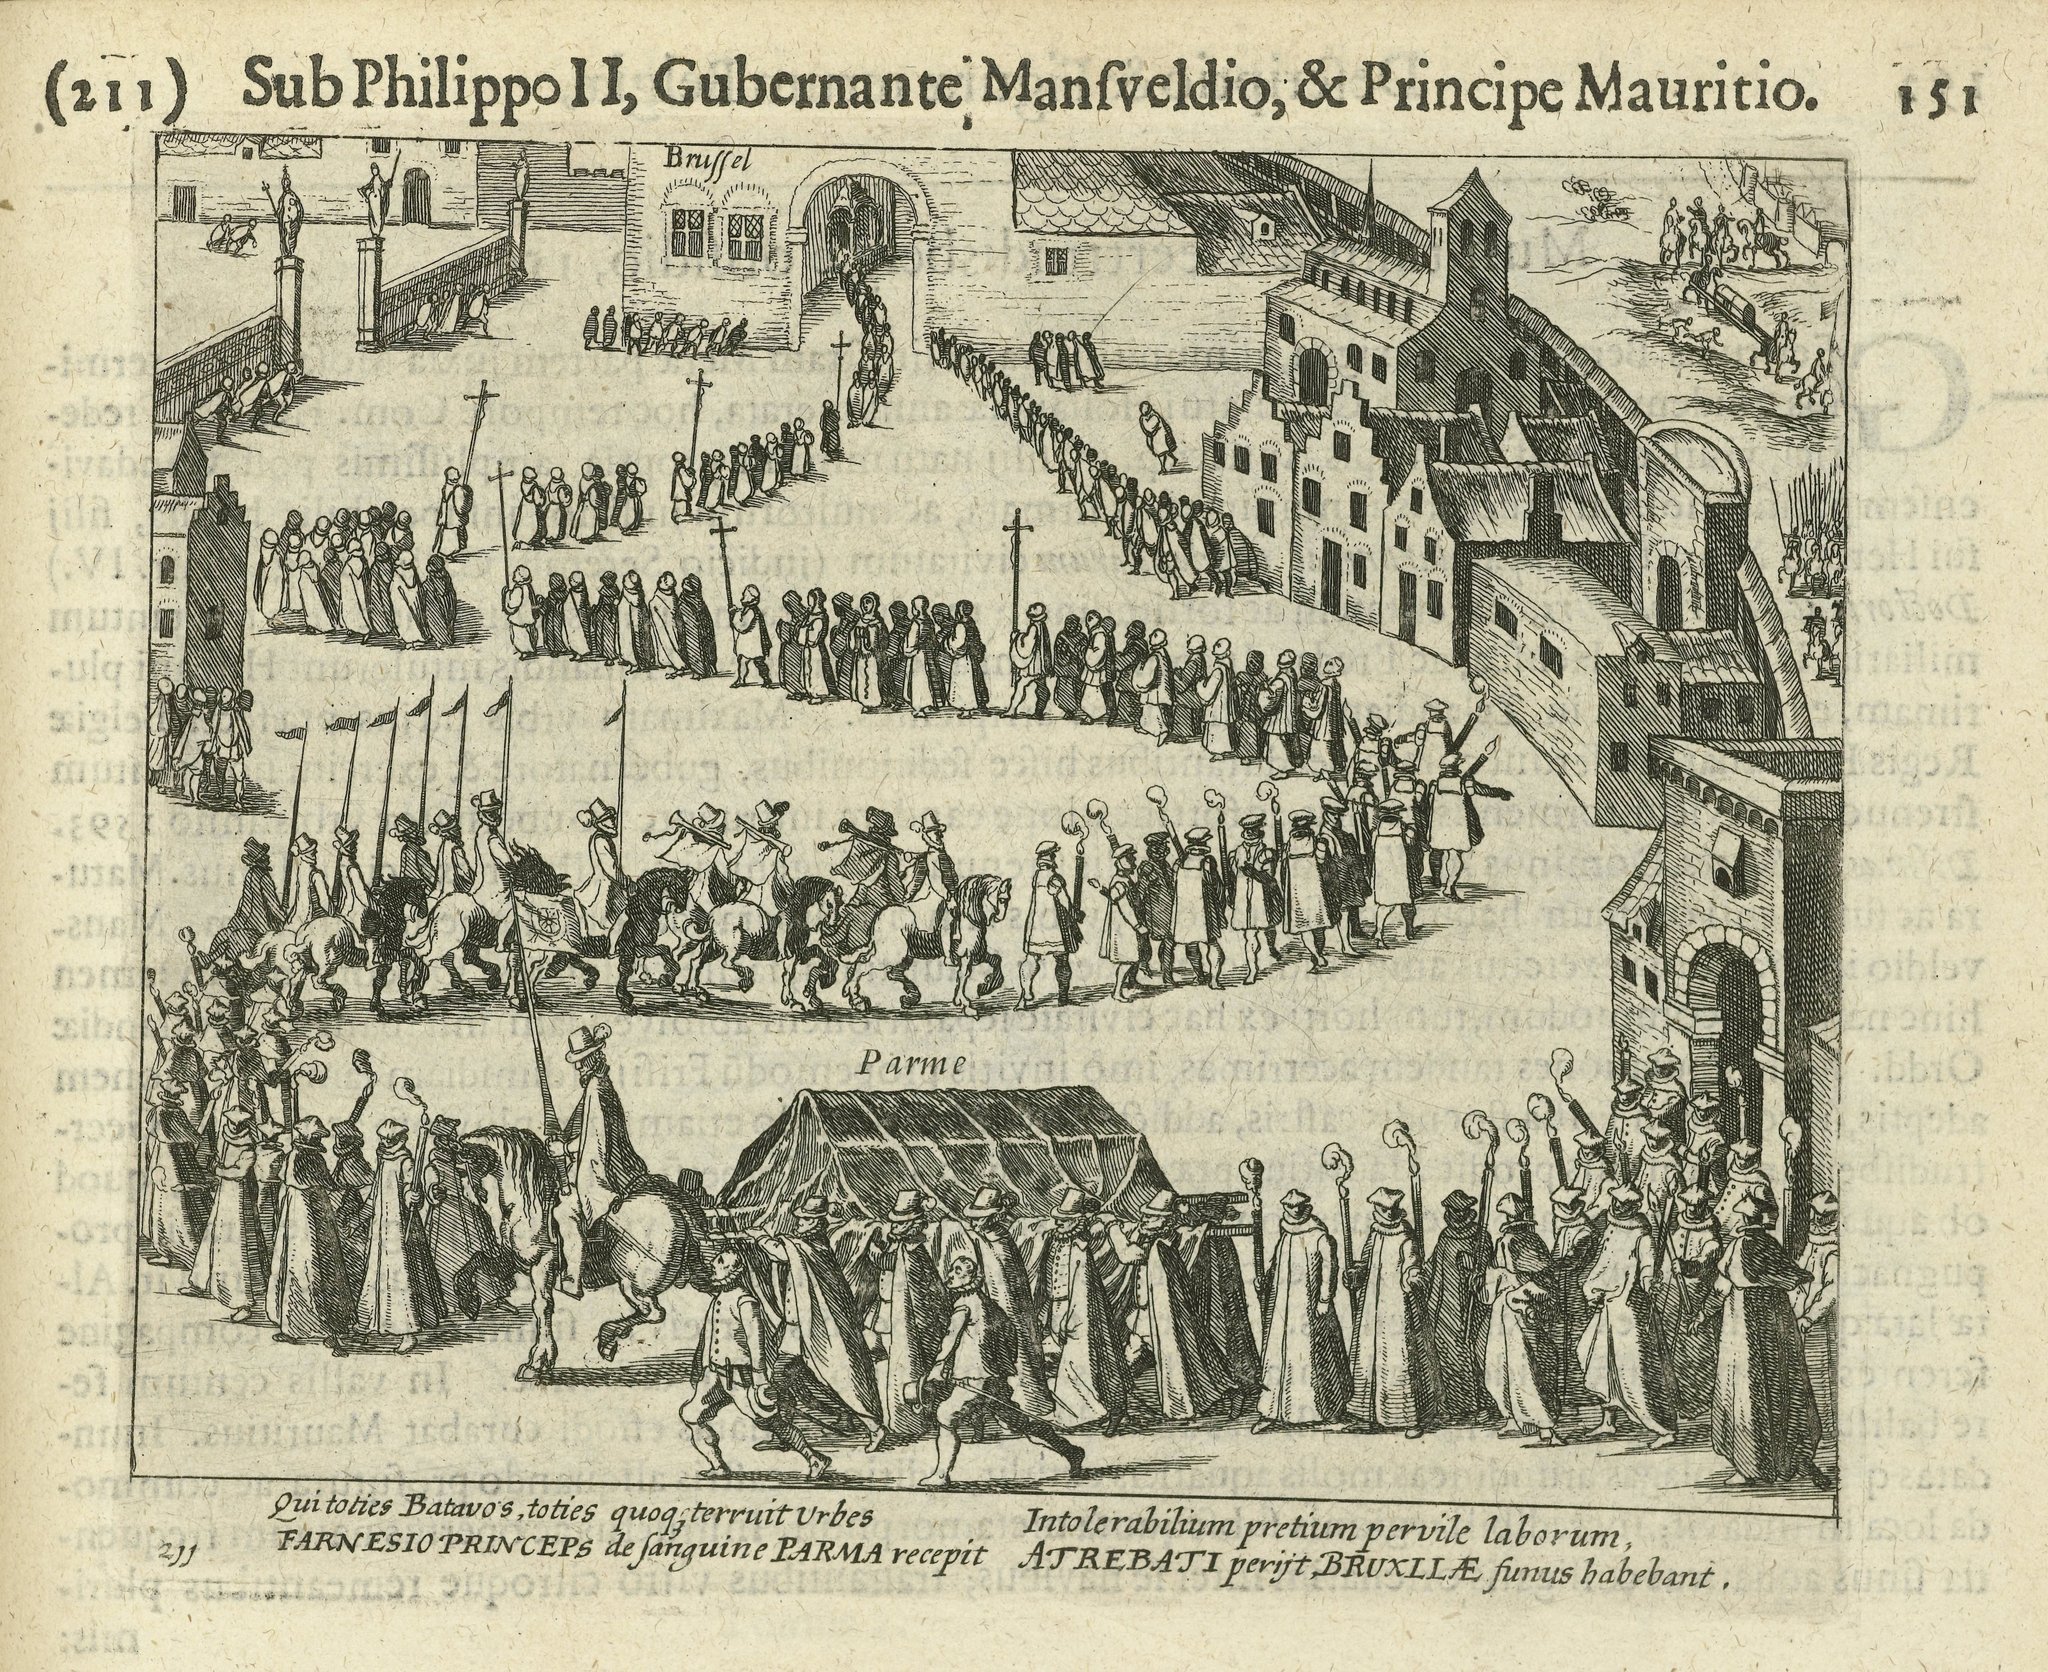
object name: print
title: Begrafenis van de hertog van Parma, 1592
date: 1613-1615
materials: paper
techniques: etching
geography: northern netherlands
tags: rome, alessandro farnese (landvoogd van de nederlanden en hertog van parma en piacenza), cortege, funeral procession, brussels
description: Lijkstatie voor de hertog van Parma te Brussel, 2 december 1592. Rouwstoet met lijkkist slingert door de straten van Brussel naar het paleis. Rechtsboven de aankomst van de kist met het lichaam van Parma vanuit Atrecht waar de hertog was overleden. Met onderschrift van 4 regels in het Latijn. Genummerd: 211. Bedrukt op achterzijde met tekst in het Latijn.